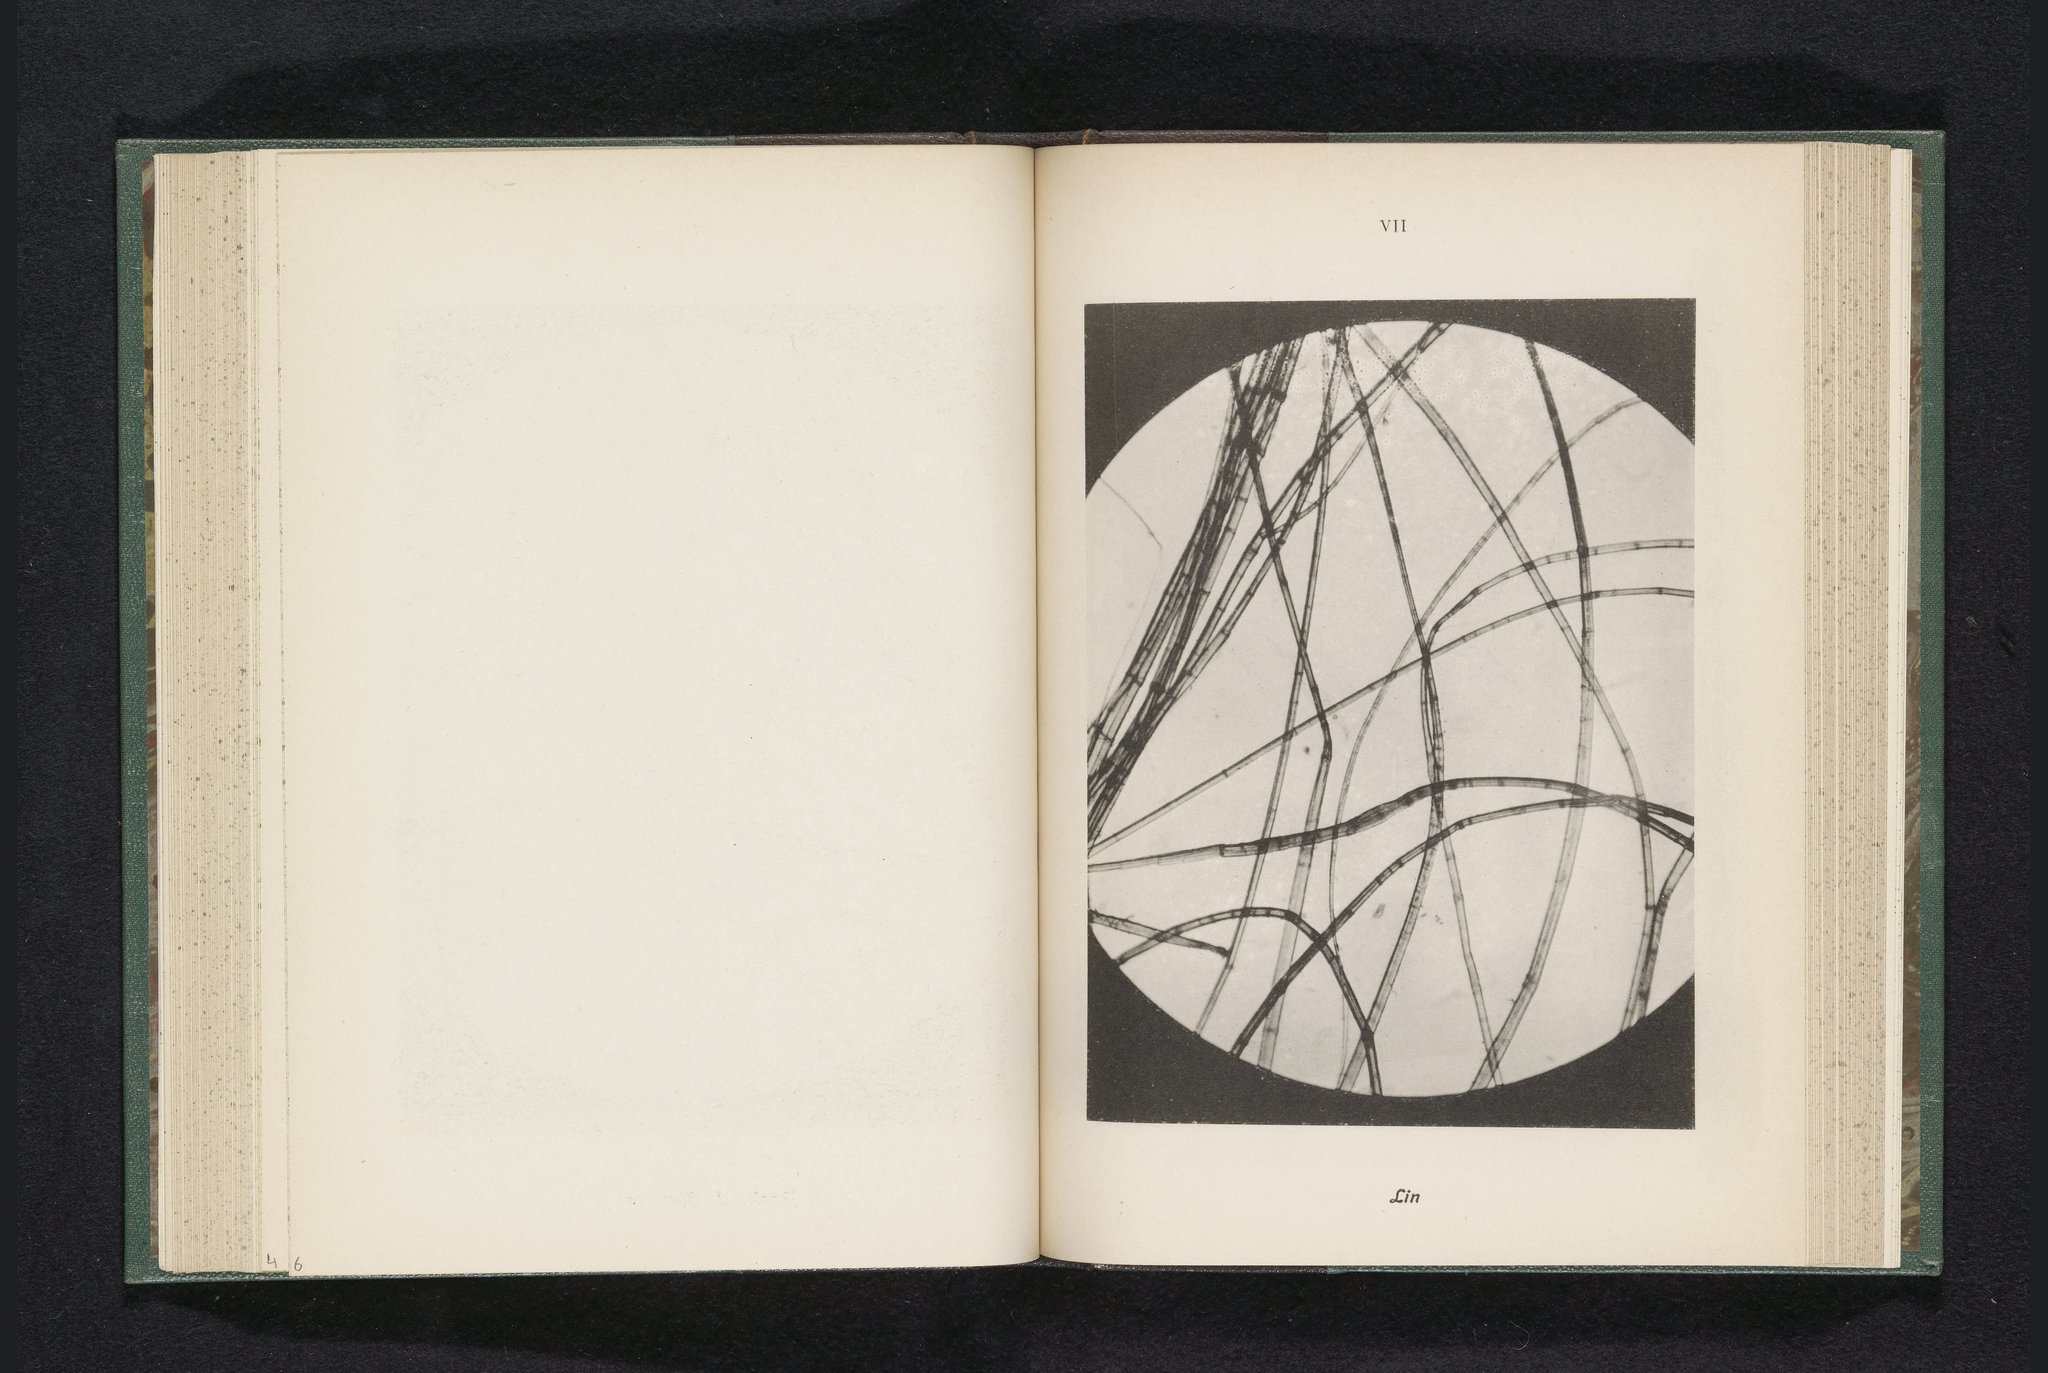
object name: page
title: Lin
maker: Anonymous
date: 1890-1900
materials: paper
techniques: photograph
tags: linen (material ~ textile industry)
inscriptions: number: ‘VII’